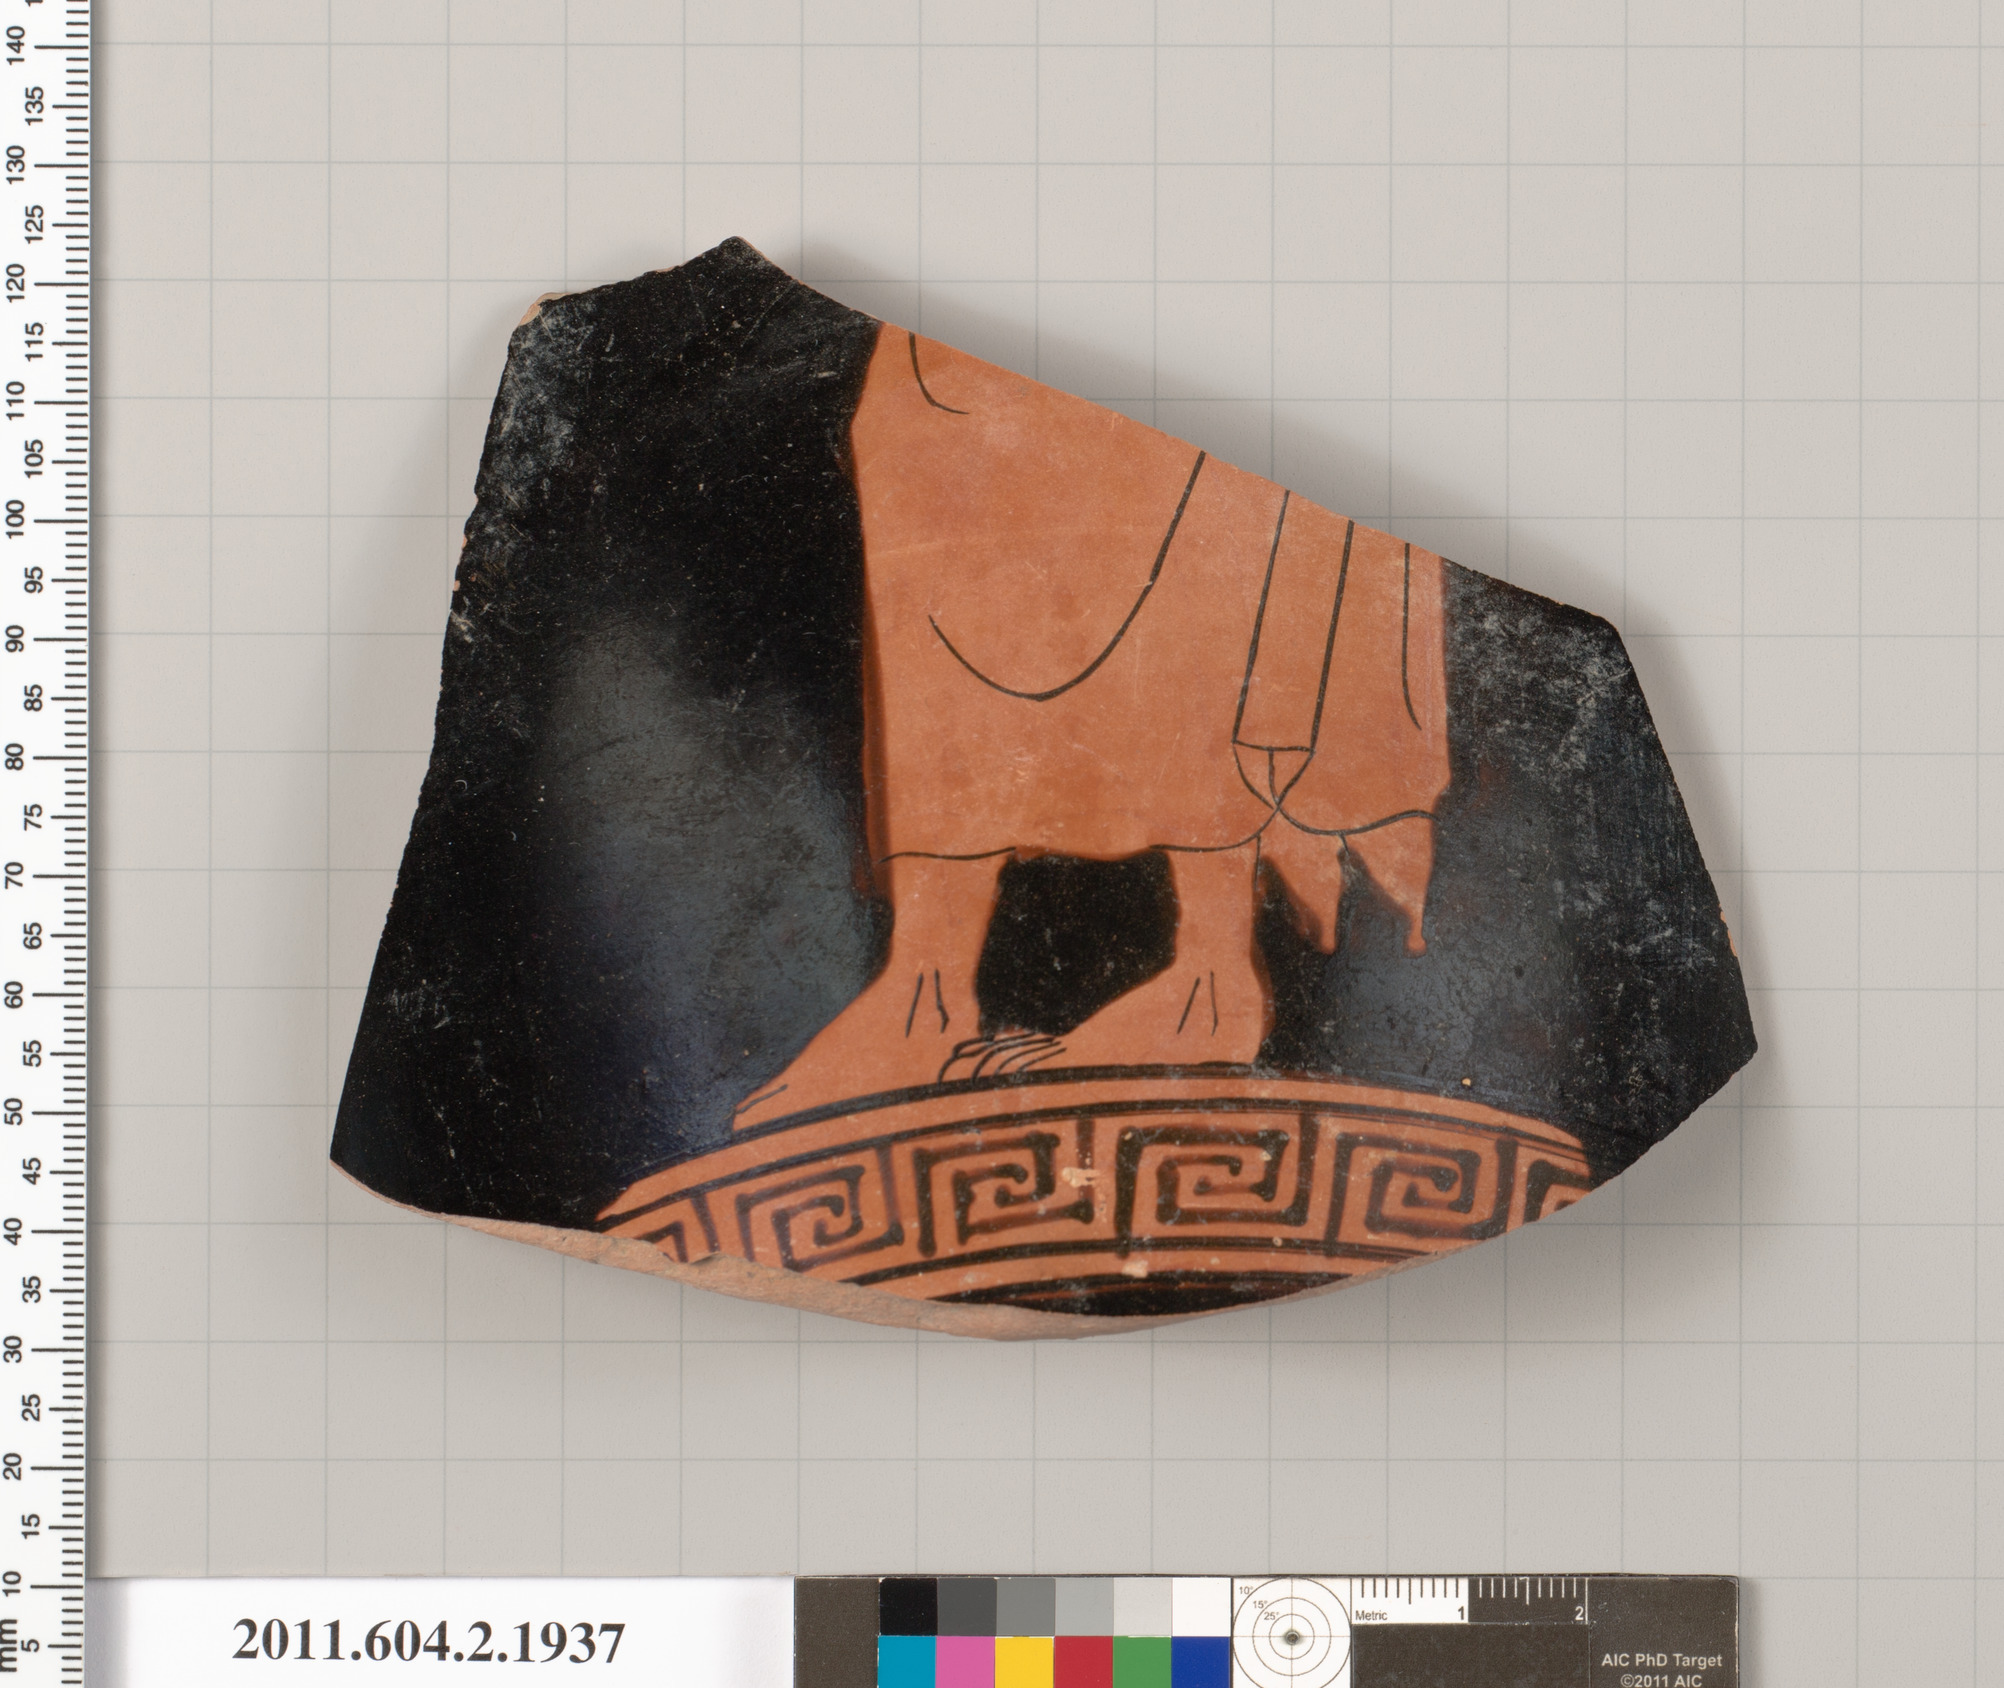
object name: neck amphora fragment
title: Terracotta fragment of a Nolan neck-amphora (jar)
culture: greek, attic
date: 475-460 BCE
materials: terracotta